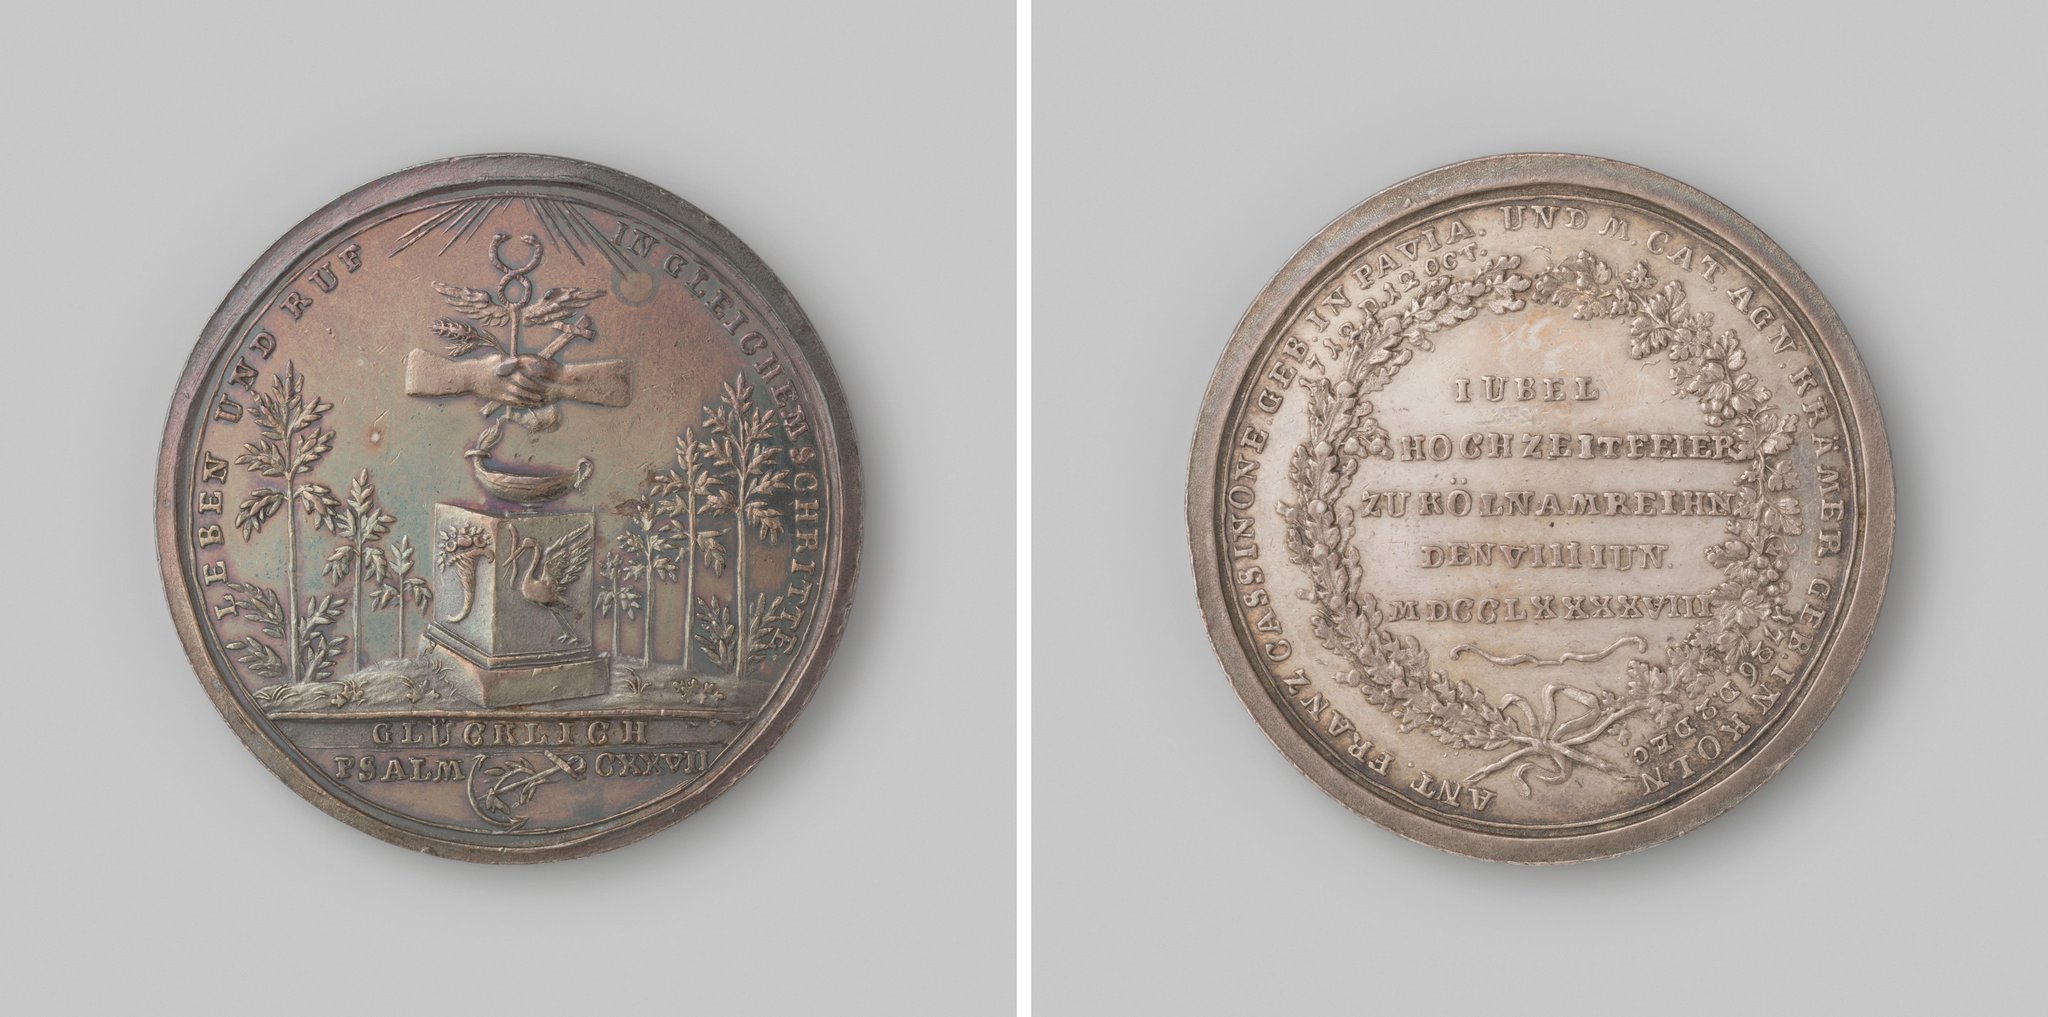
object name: history medal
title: Huwelijk van Franz Cassinone en A. Cat. Krämer te Keulen 1798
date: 1798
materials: silver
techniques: striking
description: Zilveren penning, op de voorzijde een altaar te midden van symbolische voorstellingen, met omschrift en afsnedetekst, op de keerzijde vijf regels tekst binnen een krans, met omschrift.